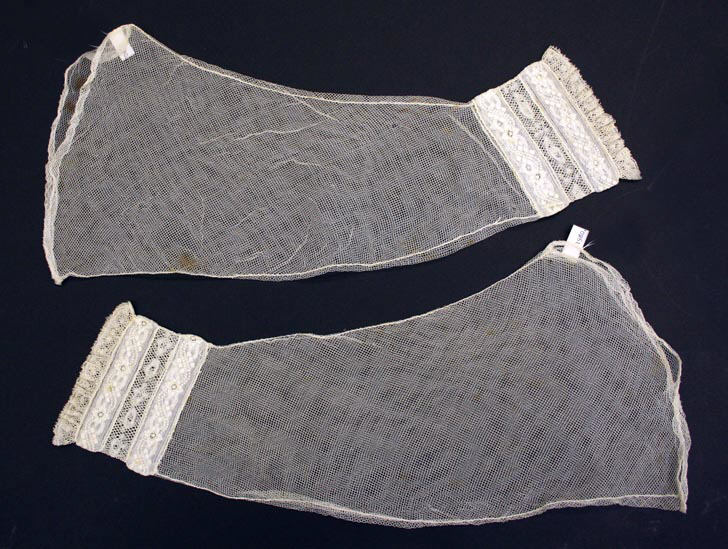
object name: undersleeves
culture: british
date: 1850-1859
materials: cotton